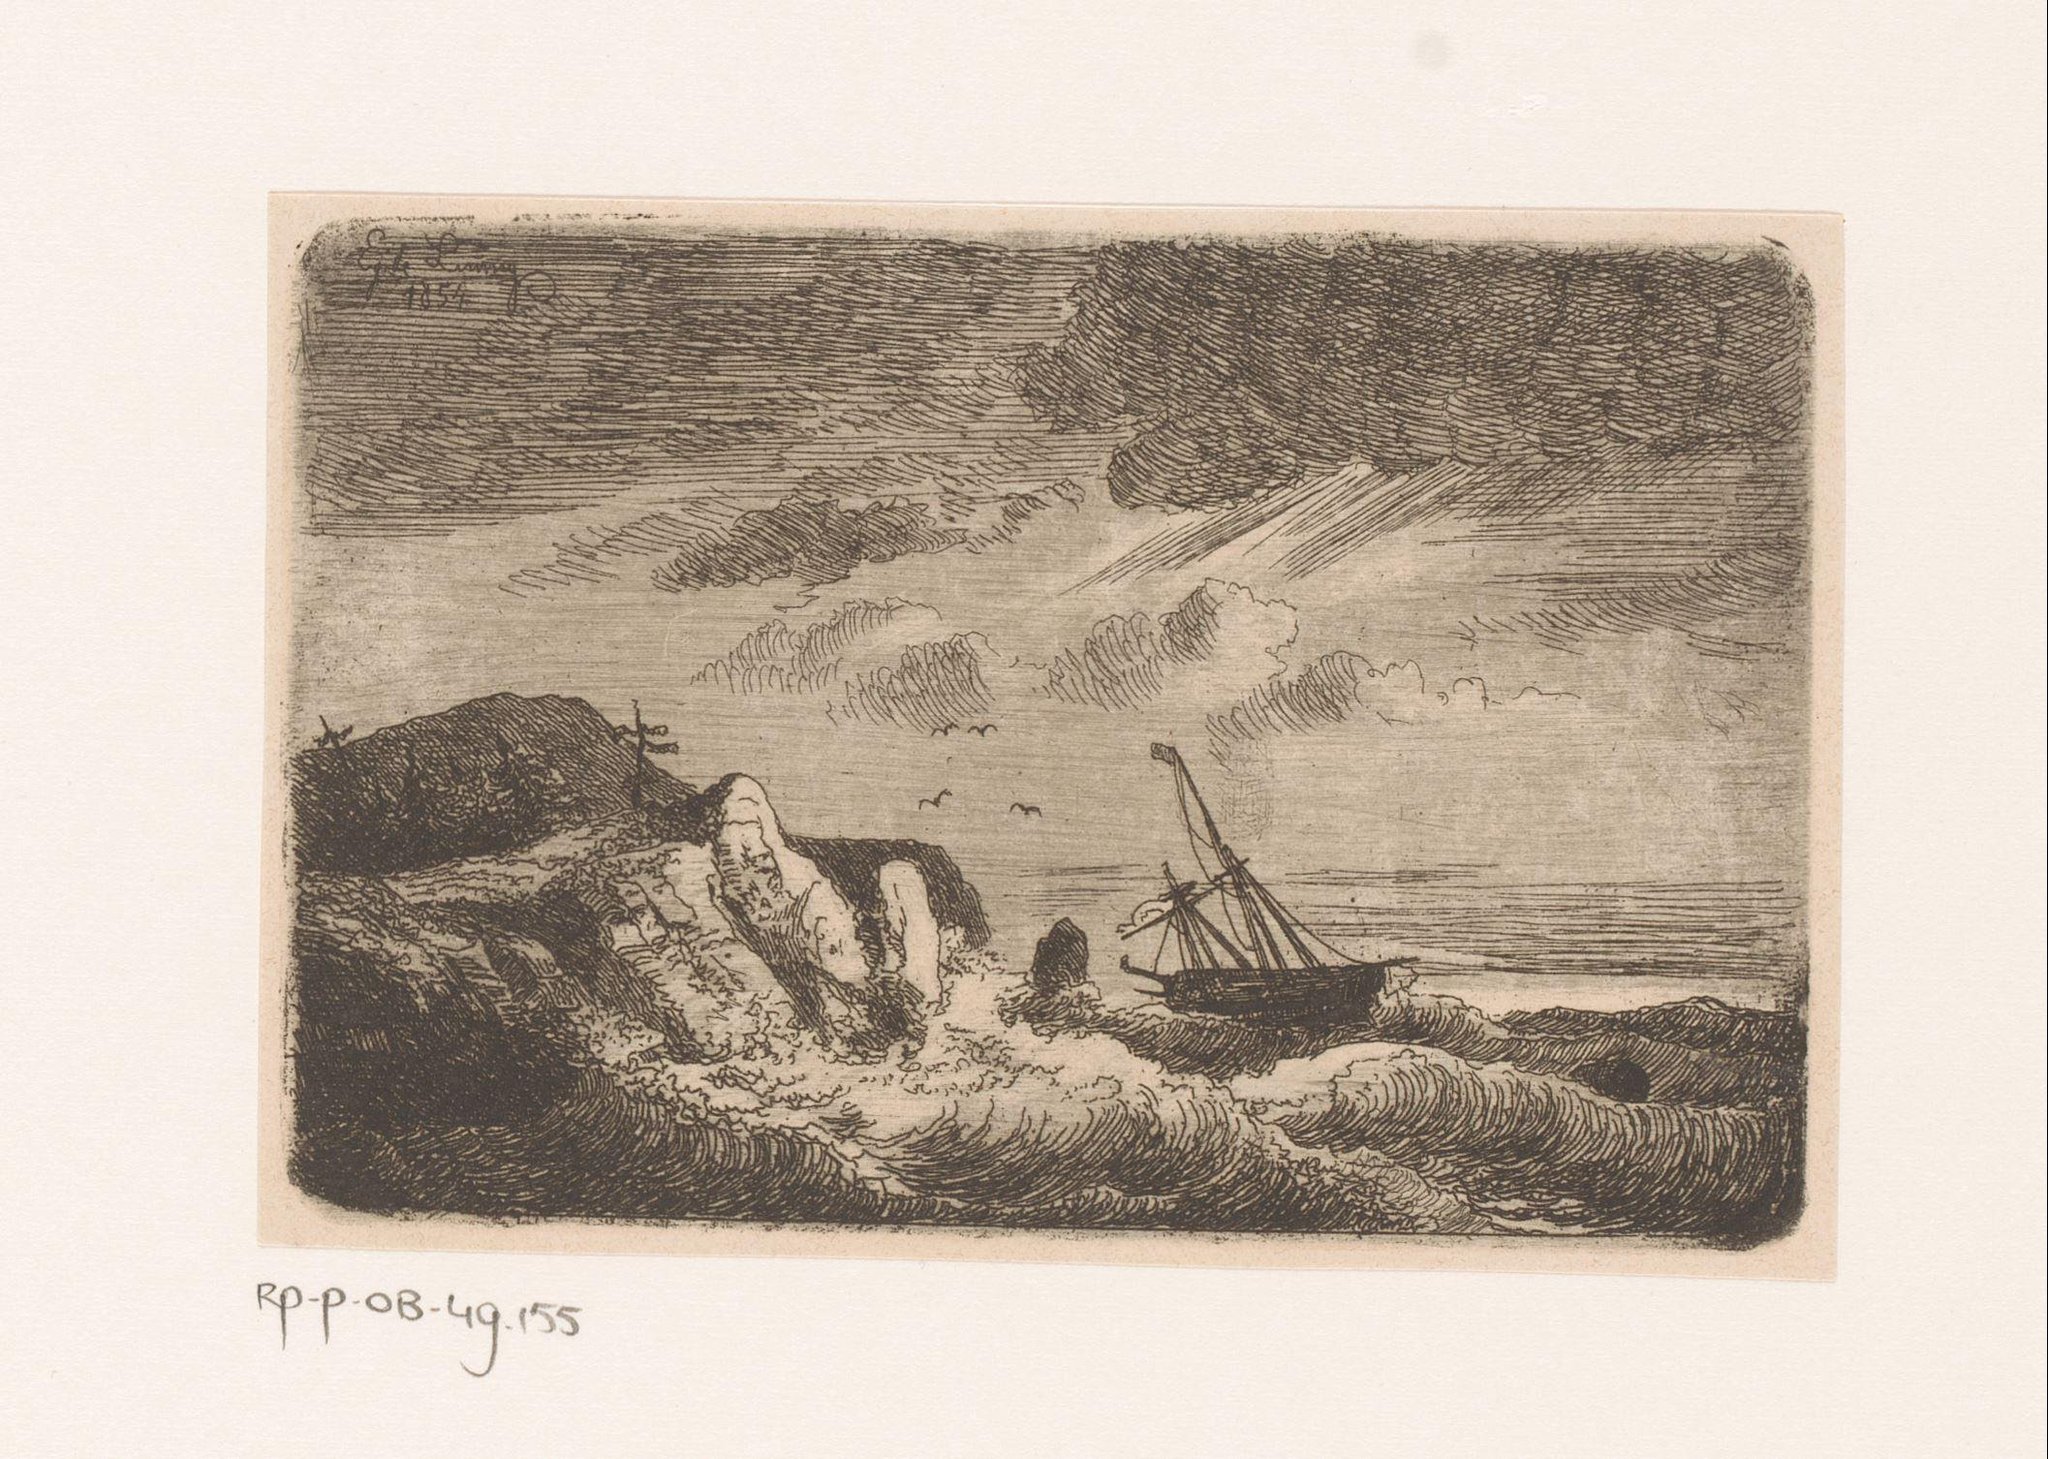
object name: print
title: Schipbreuk in de nacht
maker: egidius linnig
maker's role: draughtsman, print maker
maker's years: 1821-1860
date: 1854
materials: paper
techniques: etching, intaglio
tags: shipwreck, night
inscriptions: collector's mark: Lugt 2228